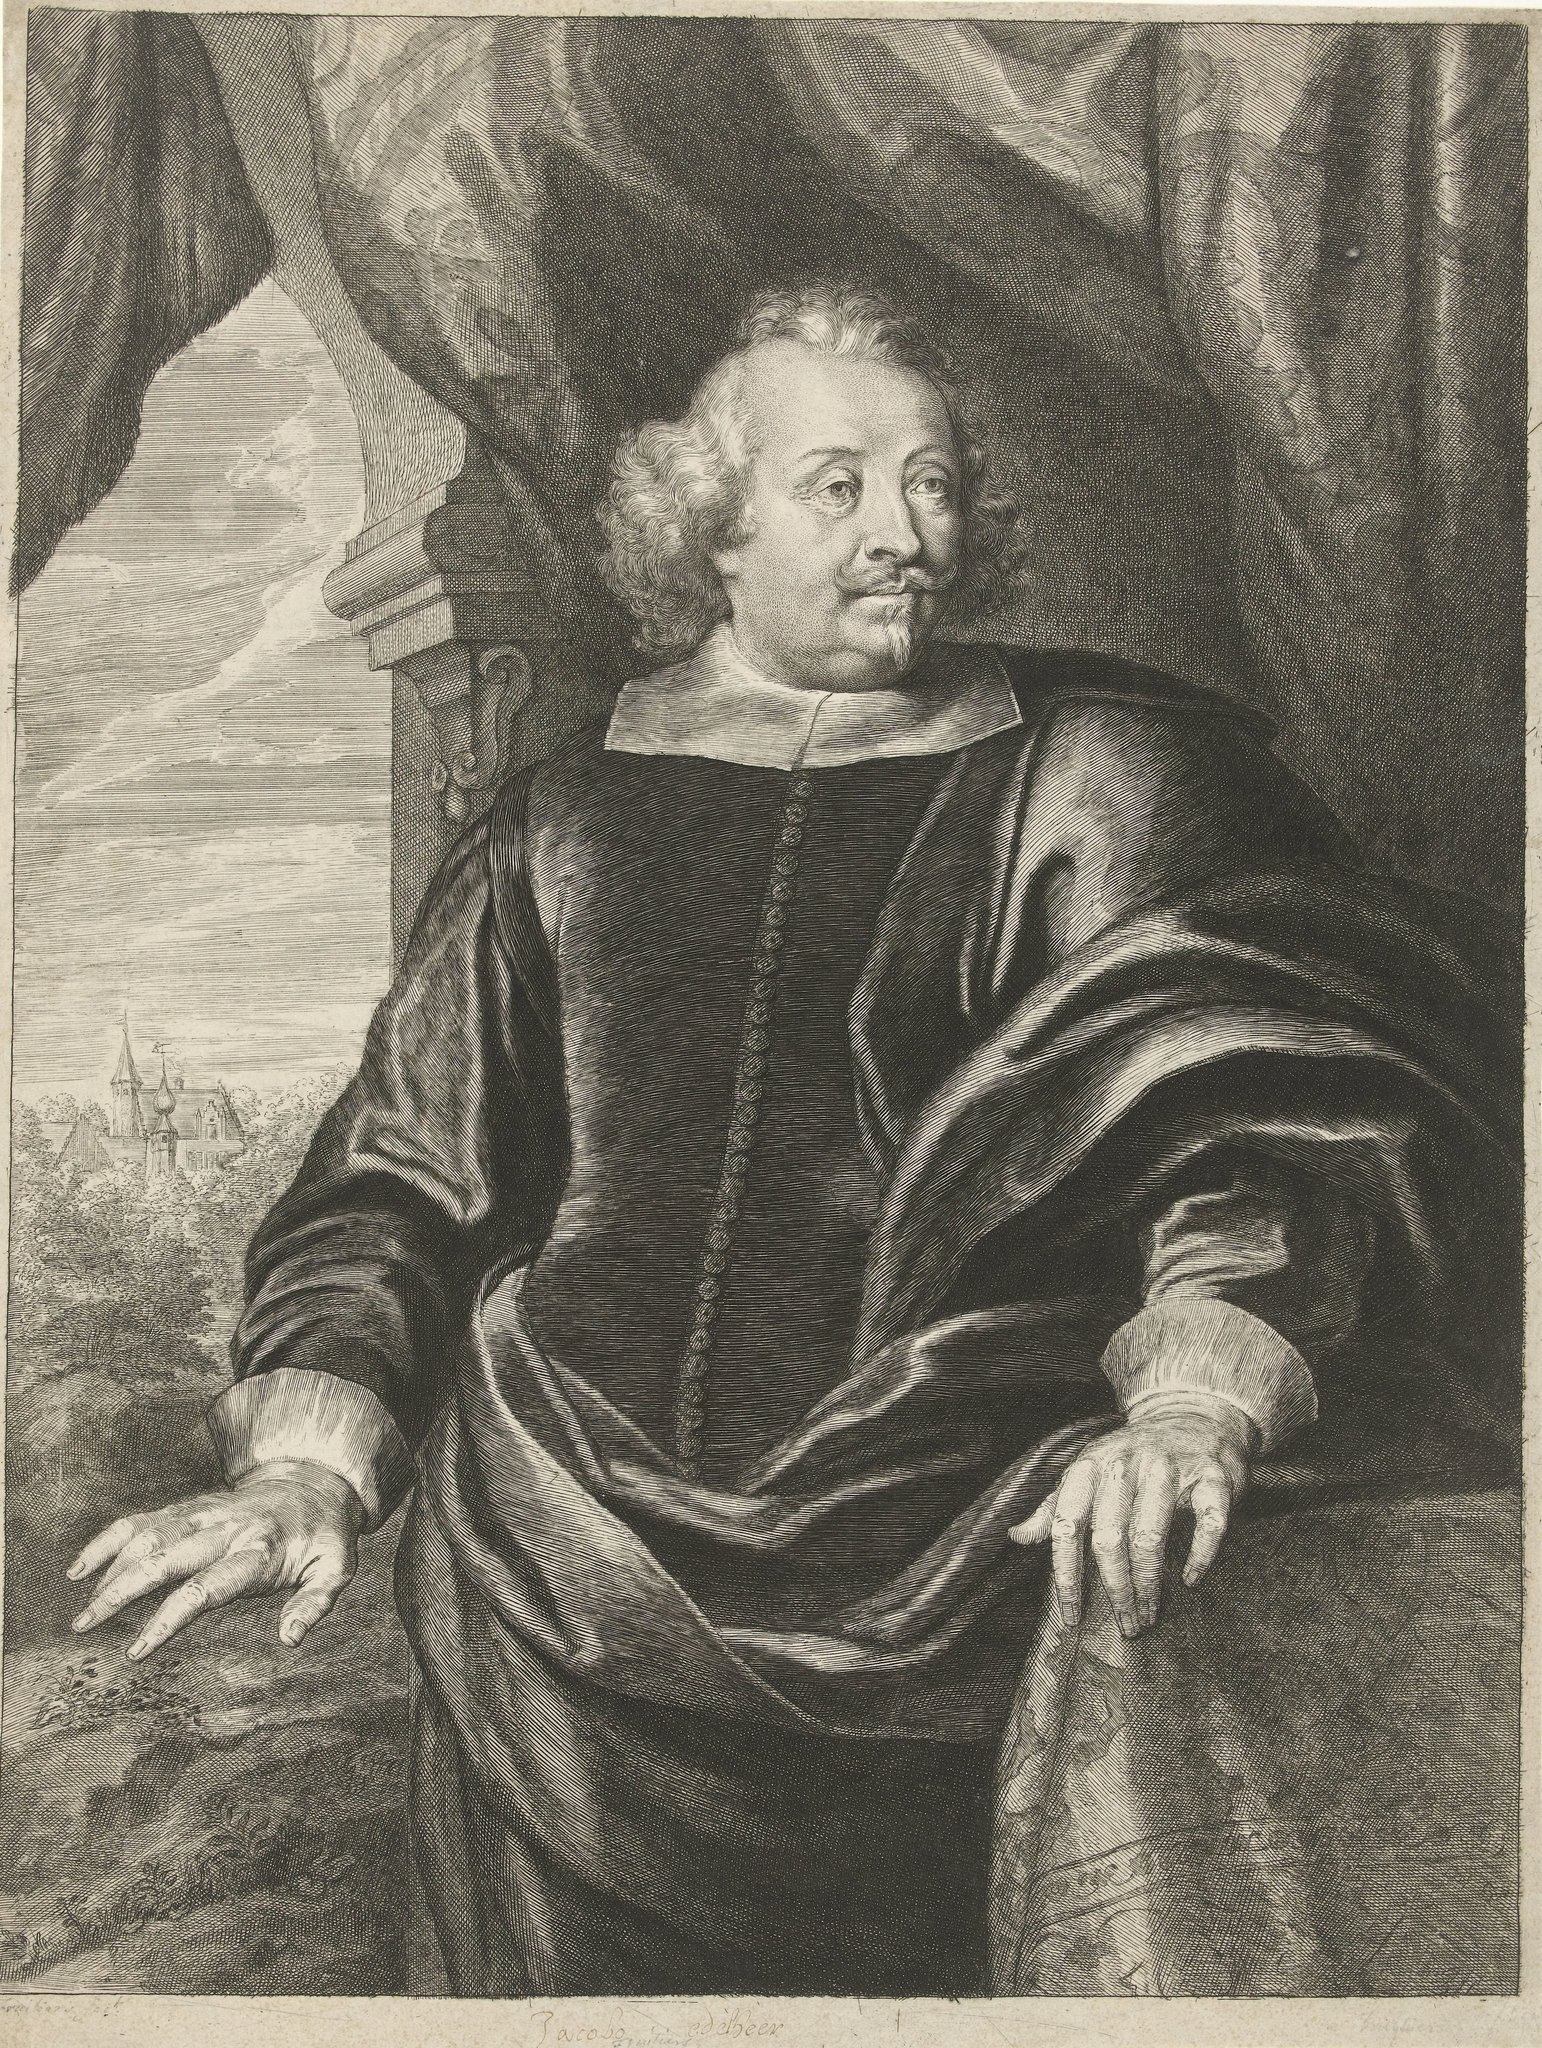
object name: book illustration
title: La Fortune et le jeune enfant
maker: johann heinrich meil (der ältere)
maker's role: print maker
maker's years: 1730-1820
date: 1758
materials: paper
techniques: etching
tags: fables of lafontaine : use 85(...), fables of lafontaine (fortuna en het kleine kind) : use 85(...), child, luck, fortune, lot; 'fato', 'fortuna', 'fortuna aurea', 'fortuna buona', 'fortuna pacifica overo clemente', 'sorte' (ripa)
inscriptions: collector's mark: Lugt 2228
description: Illustratie uit: Fontaine, J. de la. Fables choisies, mises en vers. Dl. 2. Dresden & Leipzig: George Conrad Walther, 1758.